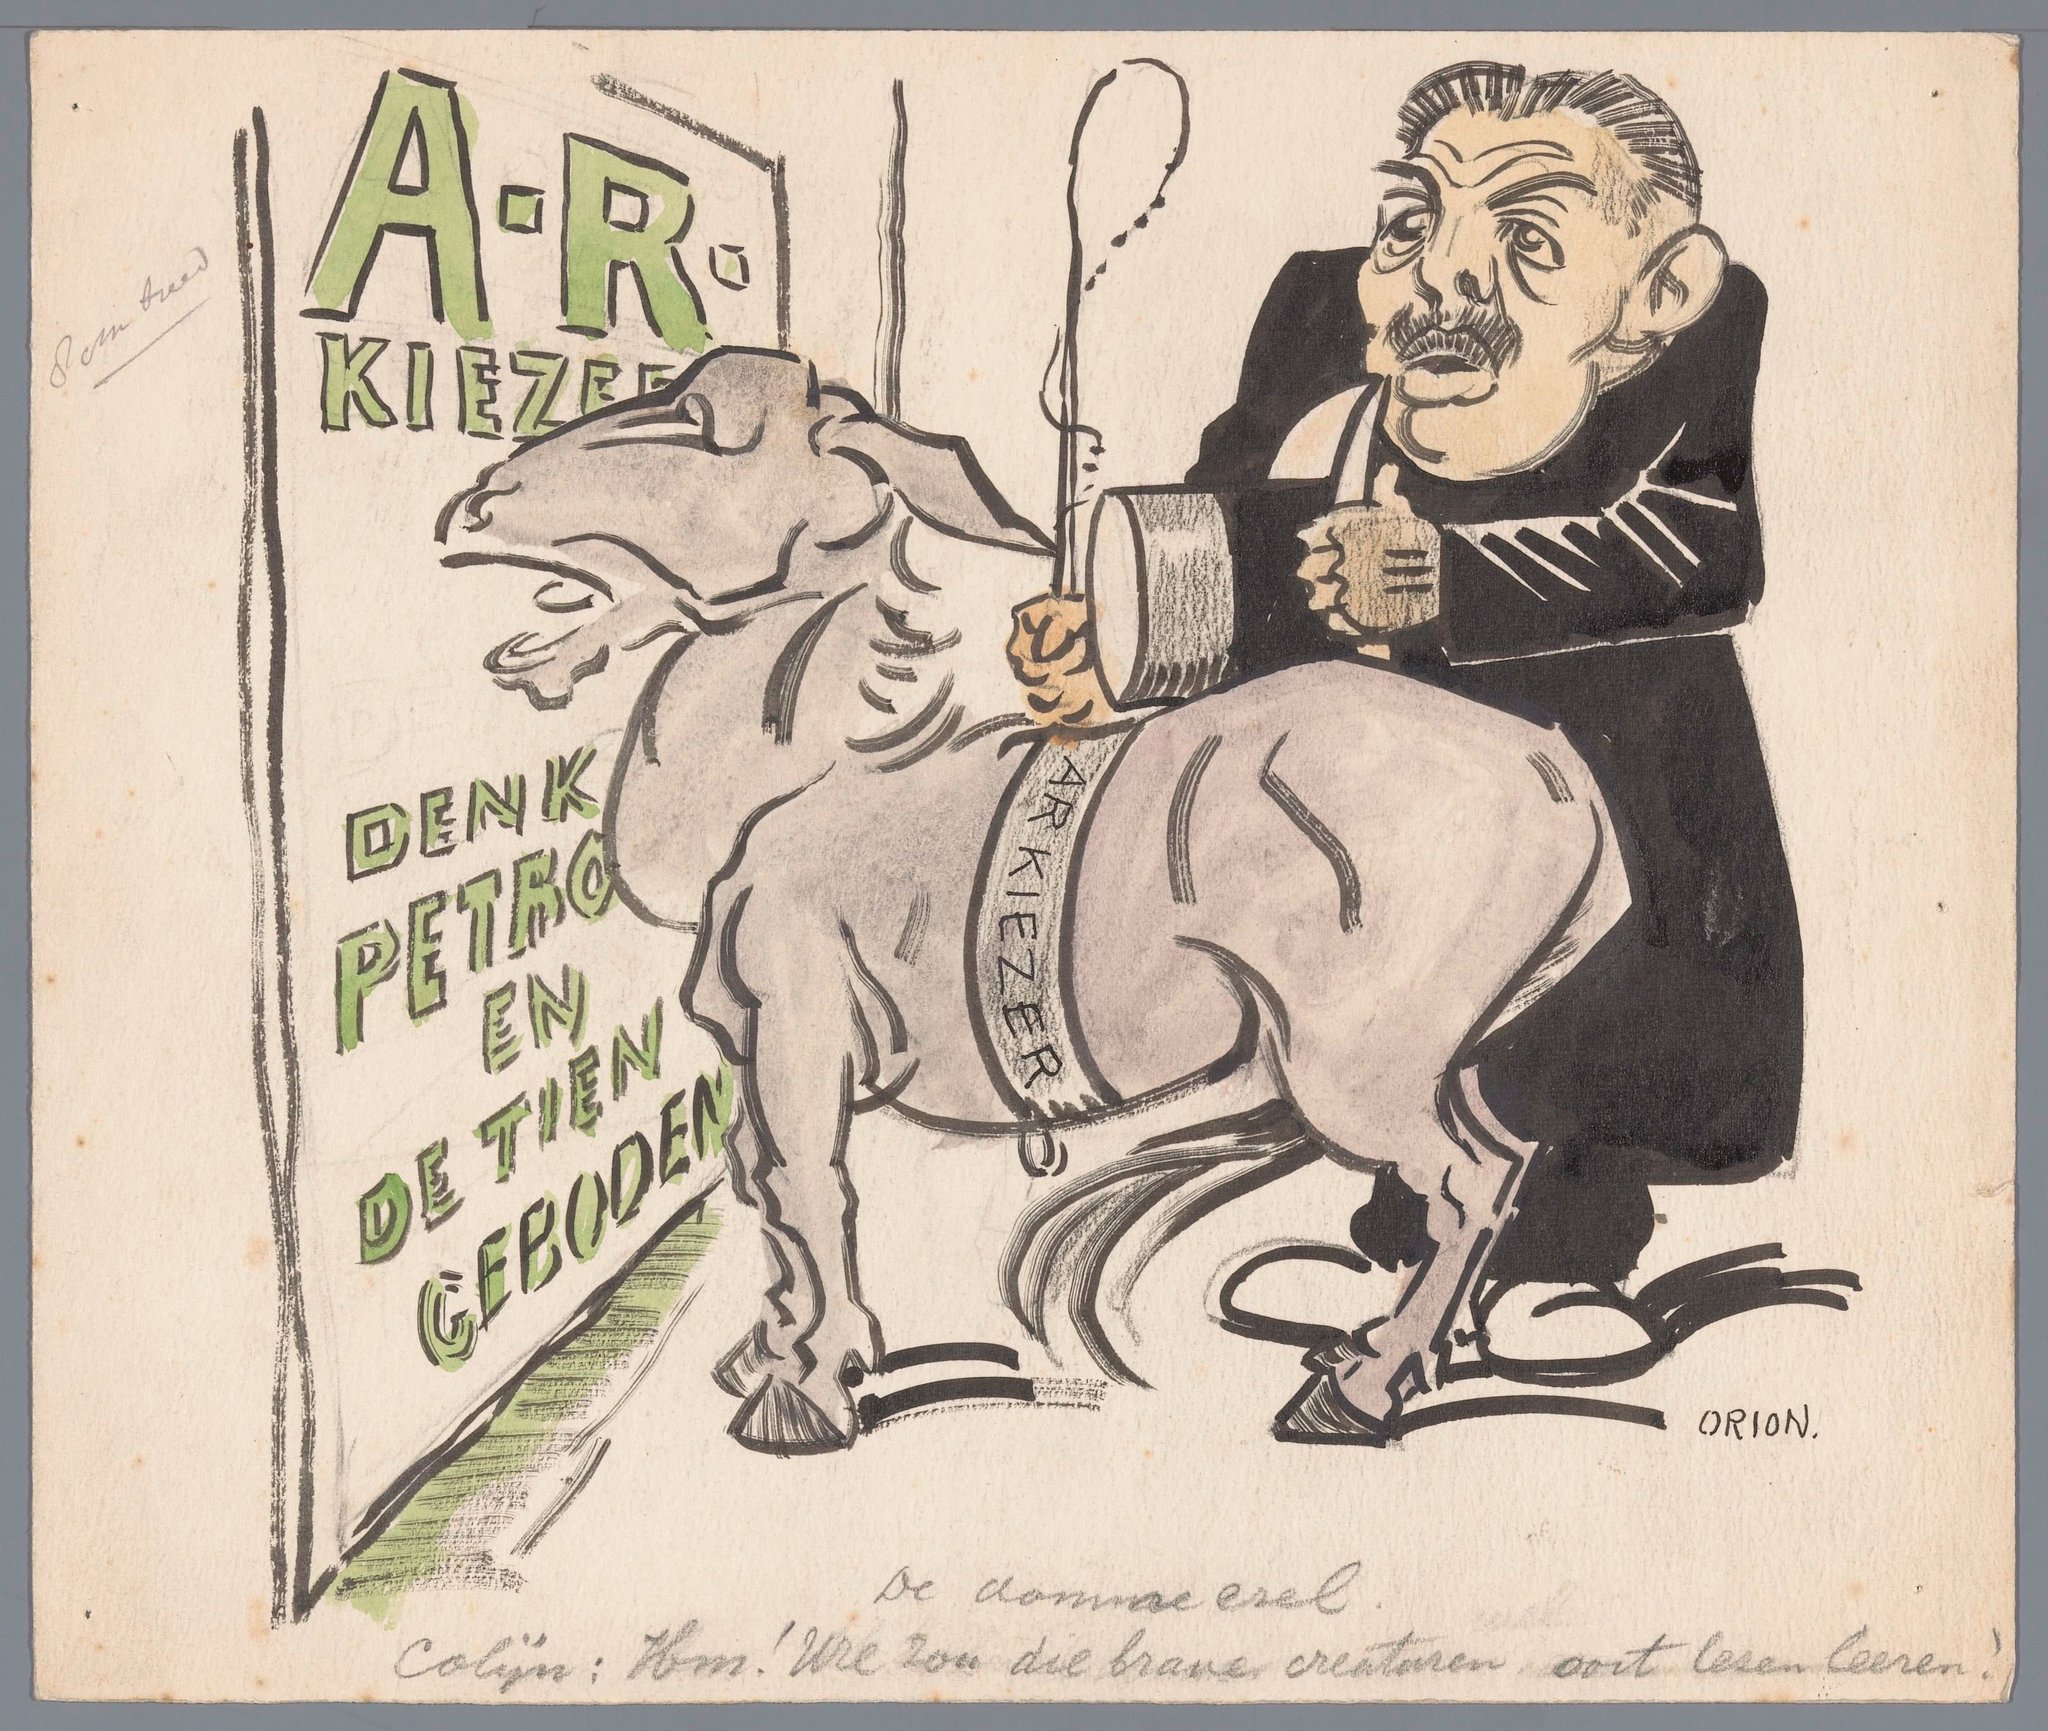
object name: drawing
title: De domme ezel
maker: patricq kroon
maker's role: draughtsman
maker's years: 1862-1941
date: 1900-1935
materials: chalk, ink, paint, paper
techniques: brush, pen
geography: netherlands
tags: hendrikus colijn, goat, political caricatures and satires, netherlands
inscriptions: inscription: ‘De domme ezel. Colijn: Kom! Wie zou die brave creaturen ooit lezen leeren?’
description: Colijn met een ezel aangeduid als de 'AR Kiezer' voor een bord met tekst. Ontwerp voor een politieke spotprent.